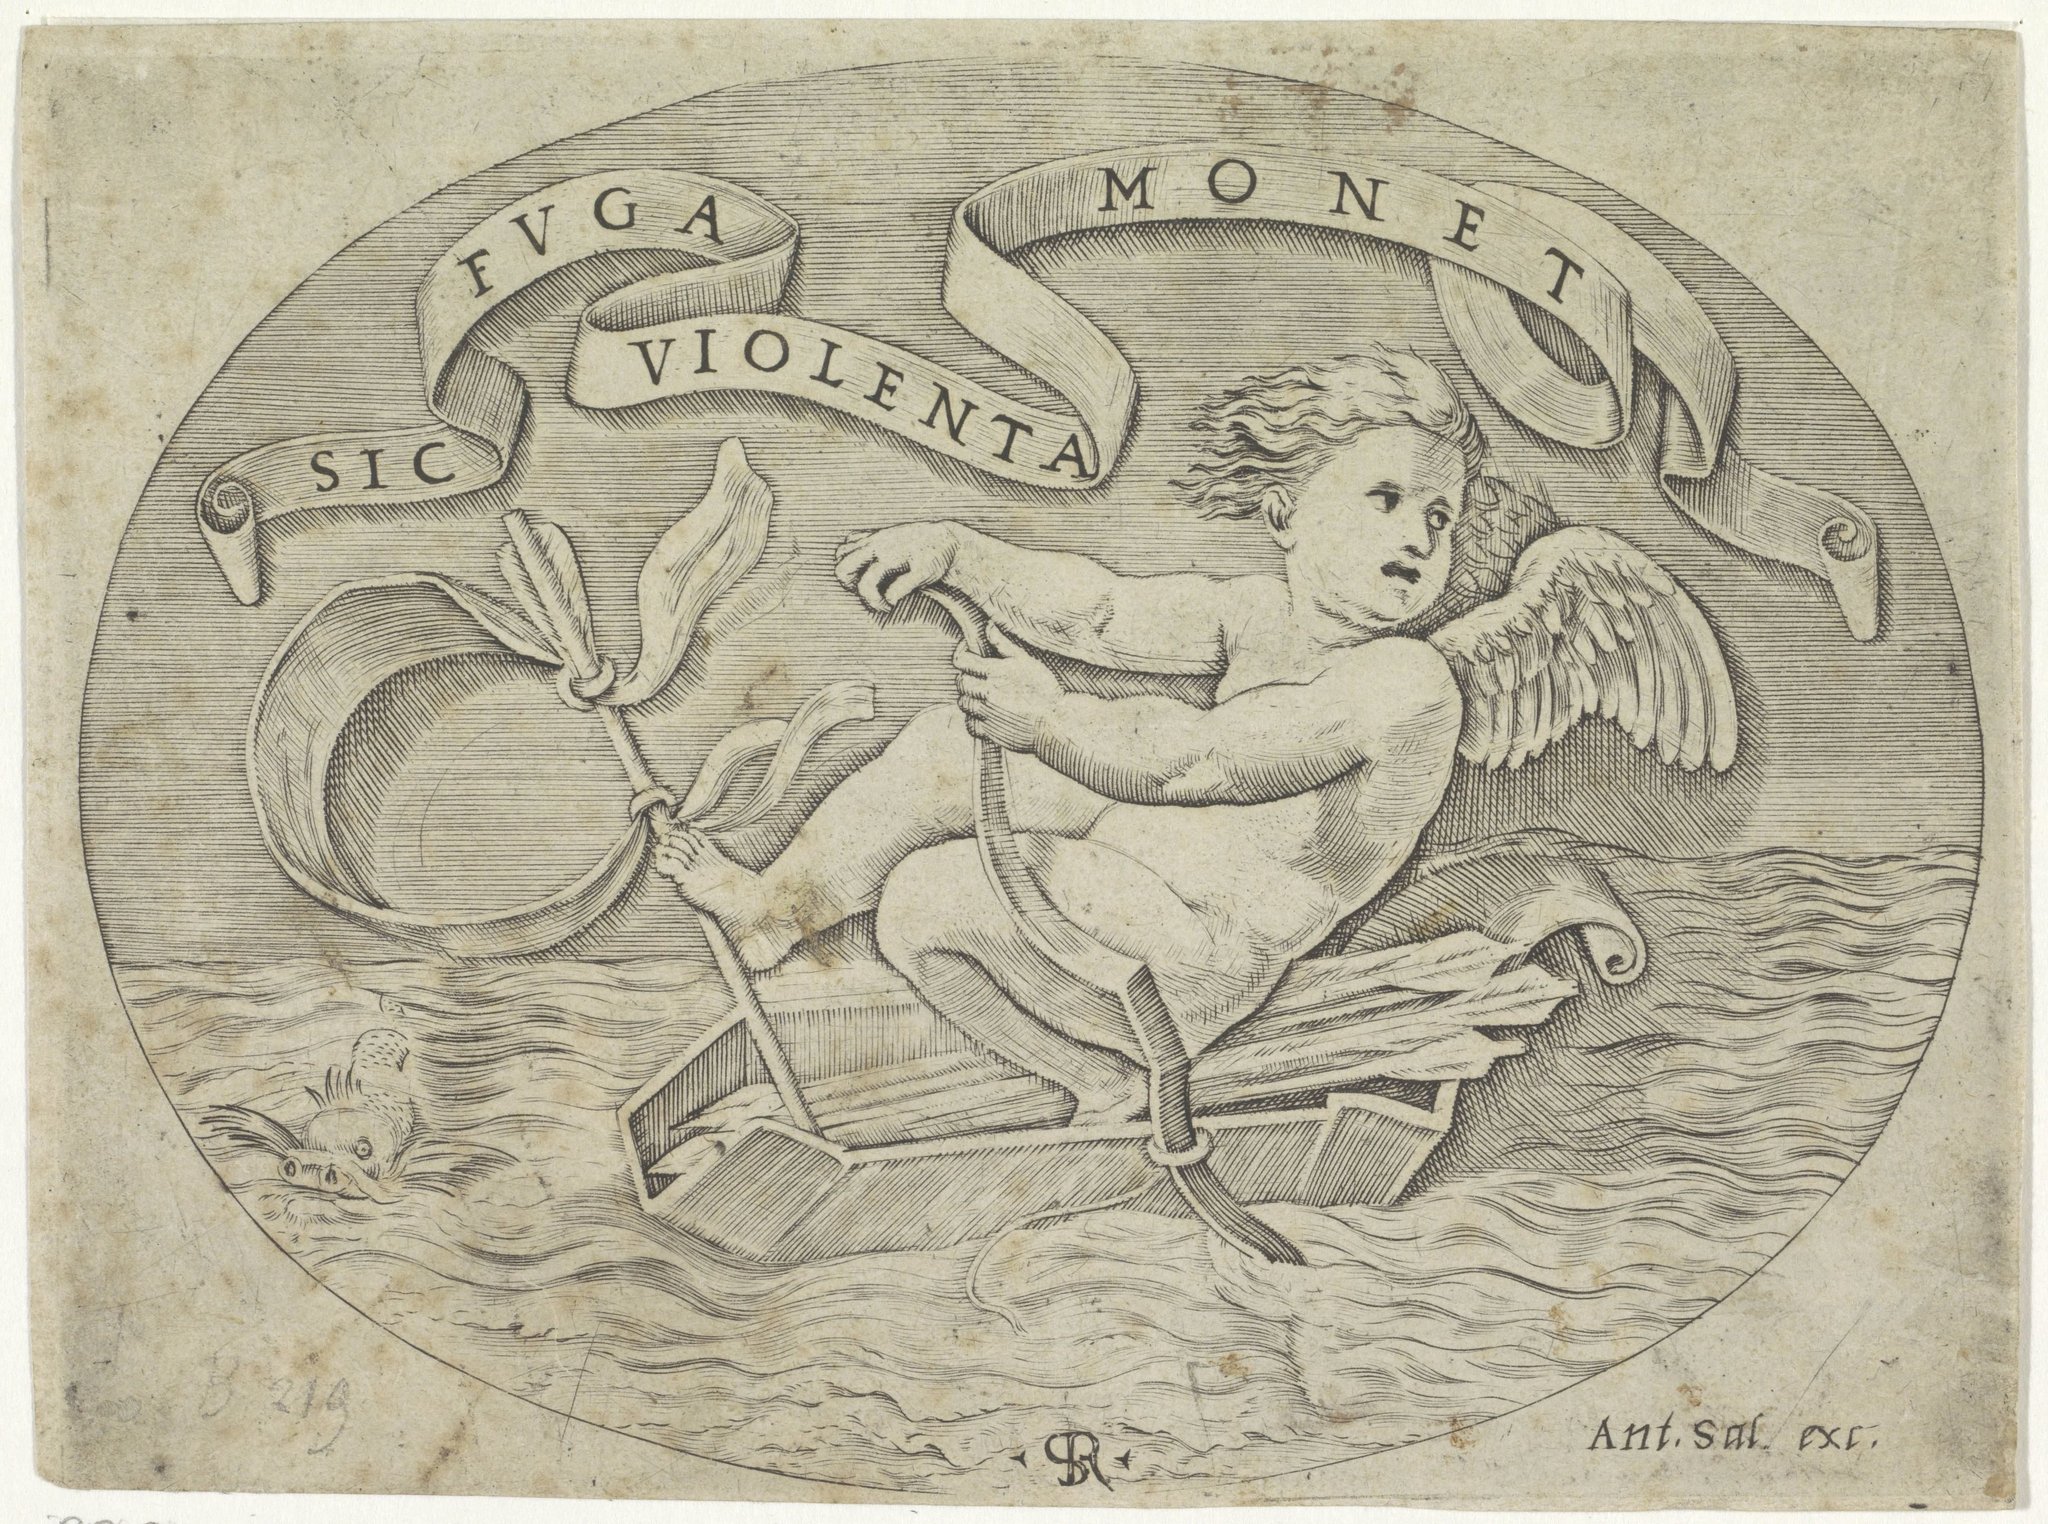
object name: print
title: Amor ontsnapt over zee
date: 1517-1562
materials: paper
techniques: engraving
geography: italy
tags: (story of) cupid, amor (eros)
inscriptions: collector's mark: Lugt 2228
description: Amor zittend in een klein bootje op zee. In het bootje liggen pijlen. Aan een pijl is een doek gebonden dat fungeert als zeil. Boven een banderol met titel.